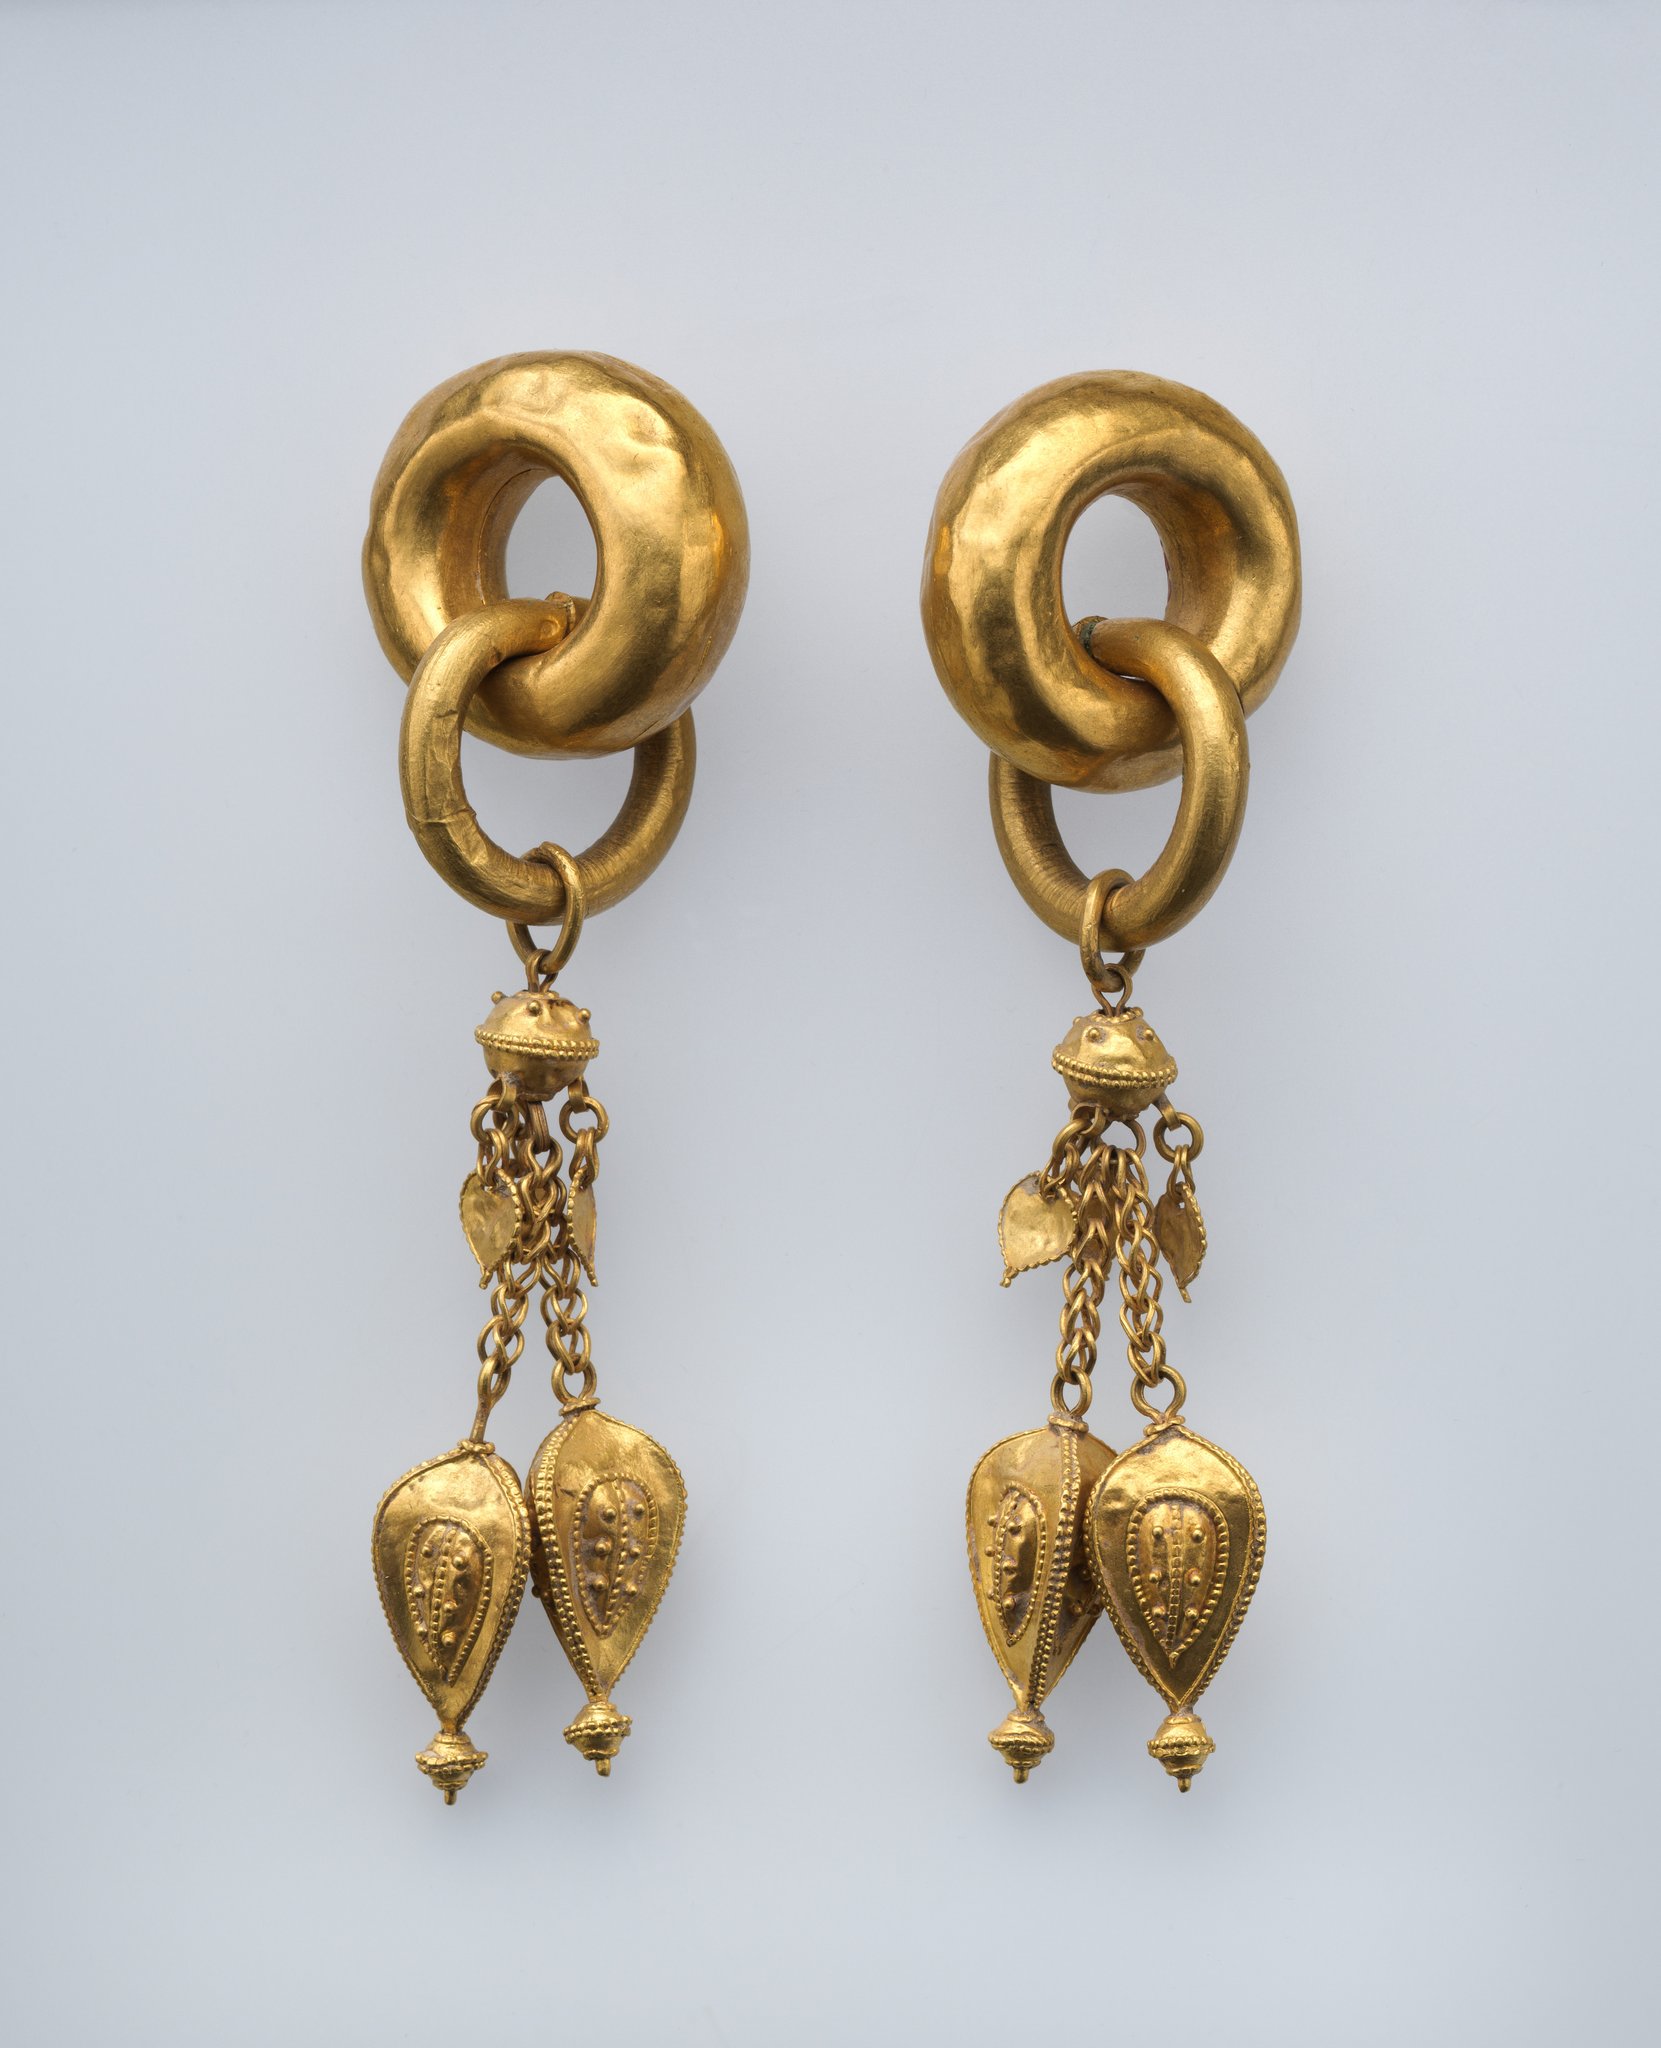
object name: earring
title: Earring (one of a pair)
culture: korean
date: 501-600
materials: gold